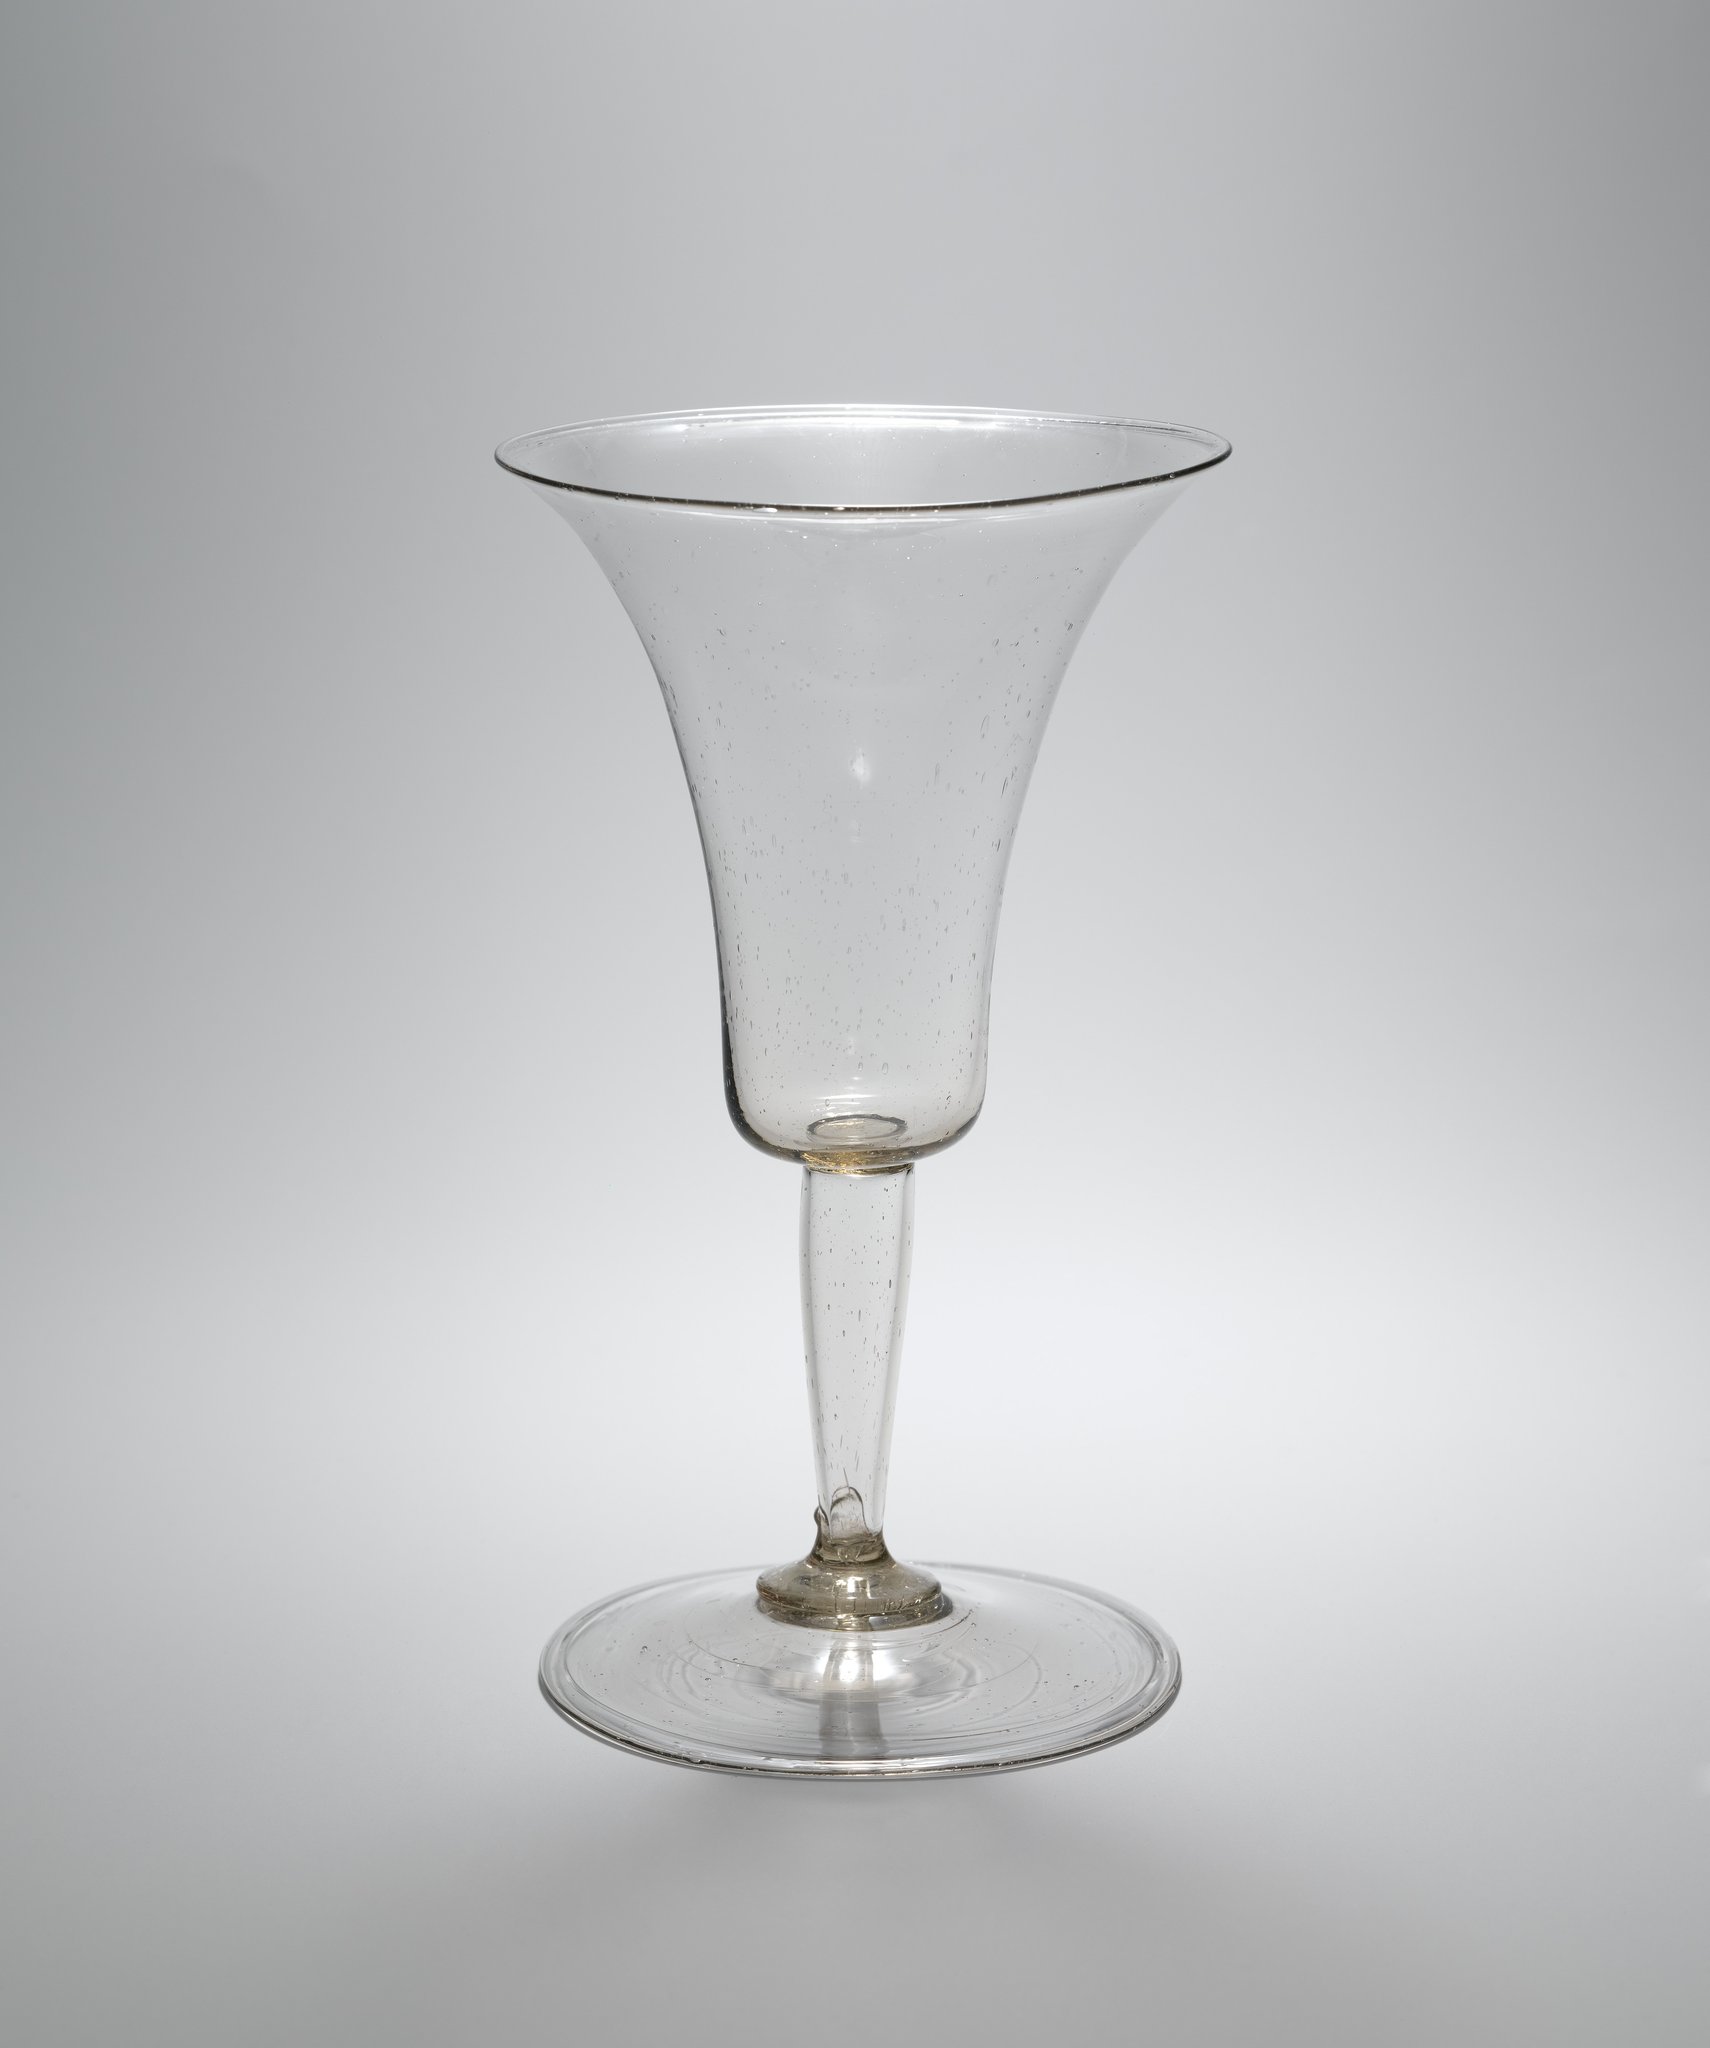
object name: wineglass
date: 1567-1633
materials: glass